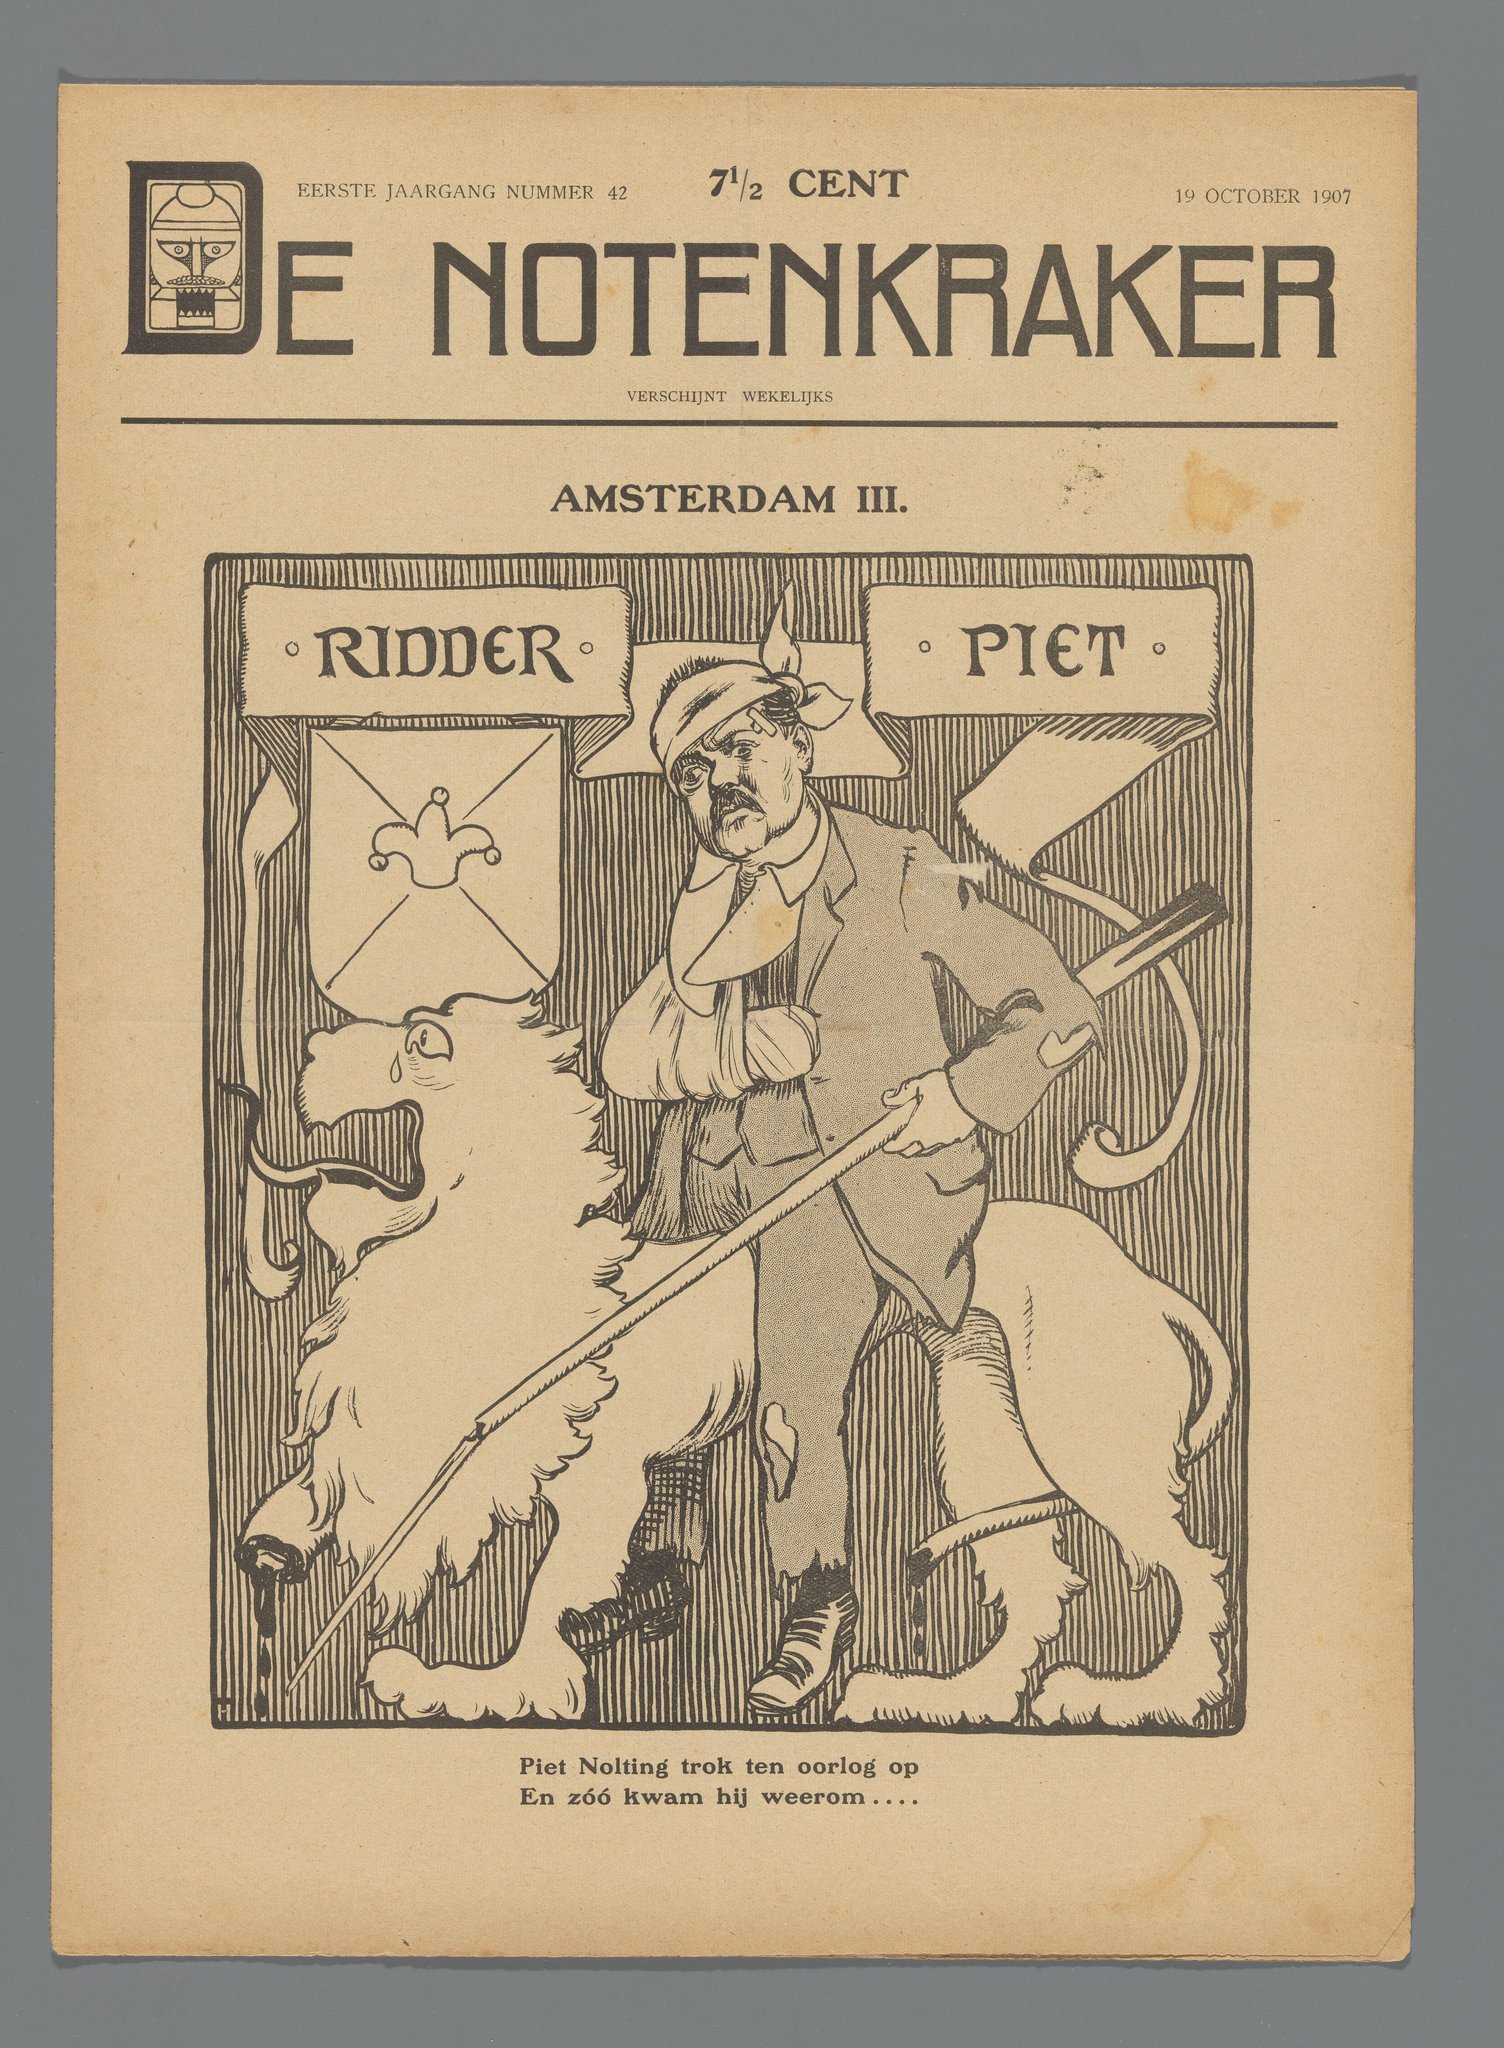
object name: print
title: De Notenkraker, 19 oktober 1907 / Amsterdam III - Ridder Piet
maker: albert hahn (i)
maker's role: draughtsman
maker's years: 1877-1918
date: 1907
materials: paper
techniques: lithograph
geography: netherlands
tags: politician, joust, tilt, political caricatures and satires, netherlands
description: Aflevering van het satirische tijdschrift De Notenkraker van 19 oktober 1907, eerste jaargang, nummer 42. Omslag met illustratie van het kamerlid Piet Nolting die als ridder gewond en rijdend op een leeuw van een verloren steekspel terugkeert. Onderdeel van een volledige eerste jaargang (1907). Elk nummer bevat 8 bladzijden, deels nog niet losgesneden, met op de voorzijde steeds een spotprent van Albert Hahn, op de overige pagina's prenten van Hahn steeds tussen de tekst. In de letter 'D' van de titel is een kop van een zgn. notenkraker afgebeeld.